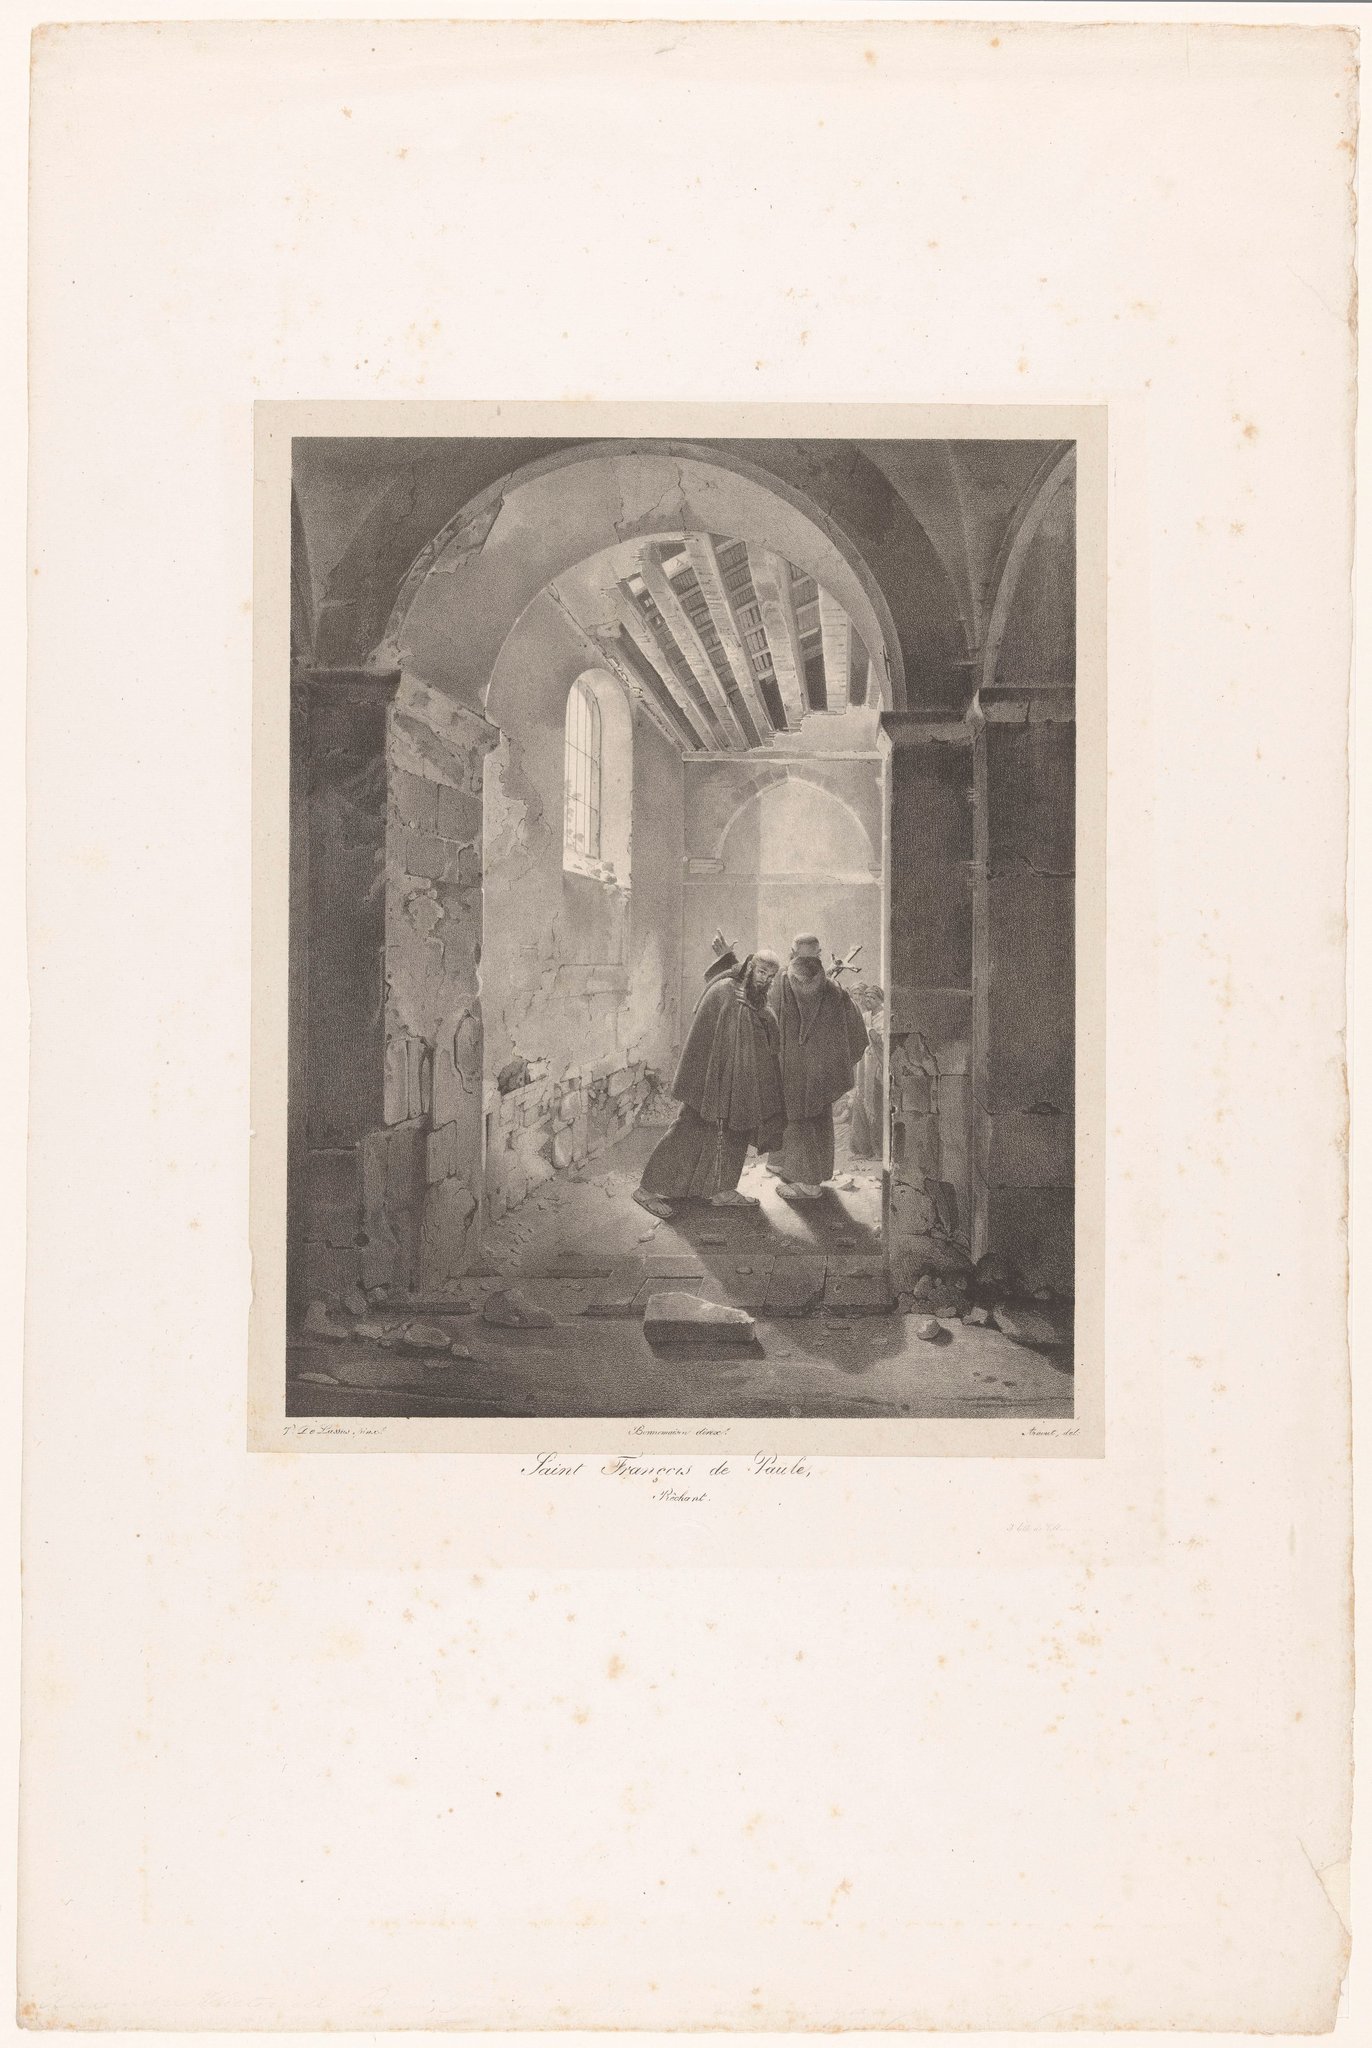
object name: print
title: Franciscus van Paola predikt in de ruïne van een kapel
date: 1818-1826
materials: paper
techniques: lithograph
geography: paris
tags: ruin of church, monastery, etc. - qq - small church, chapel, the hermit and founder of the (franciscan) minim friars, francis of paola; possible attributes: inscription 'charitas' on breast, discipline, skull, staff, parts of church interior, preaching (in general)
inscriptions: check stamp: Lugt 4729